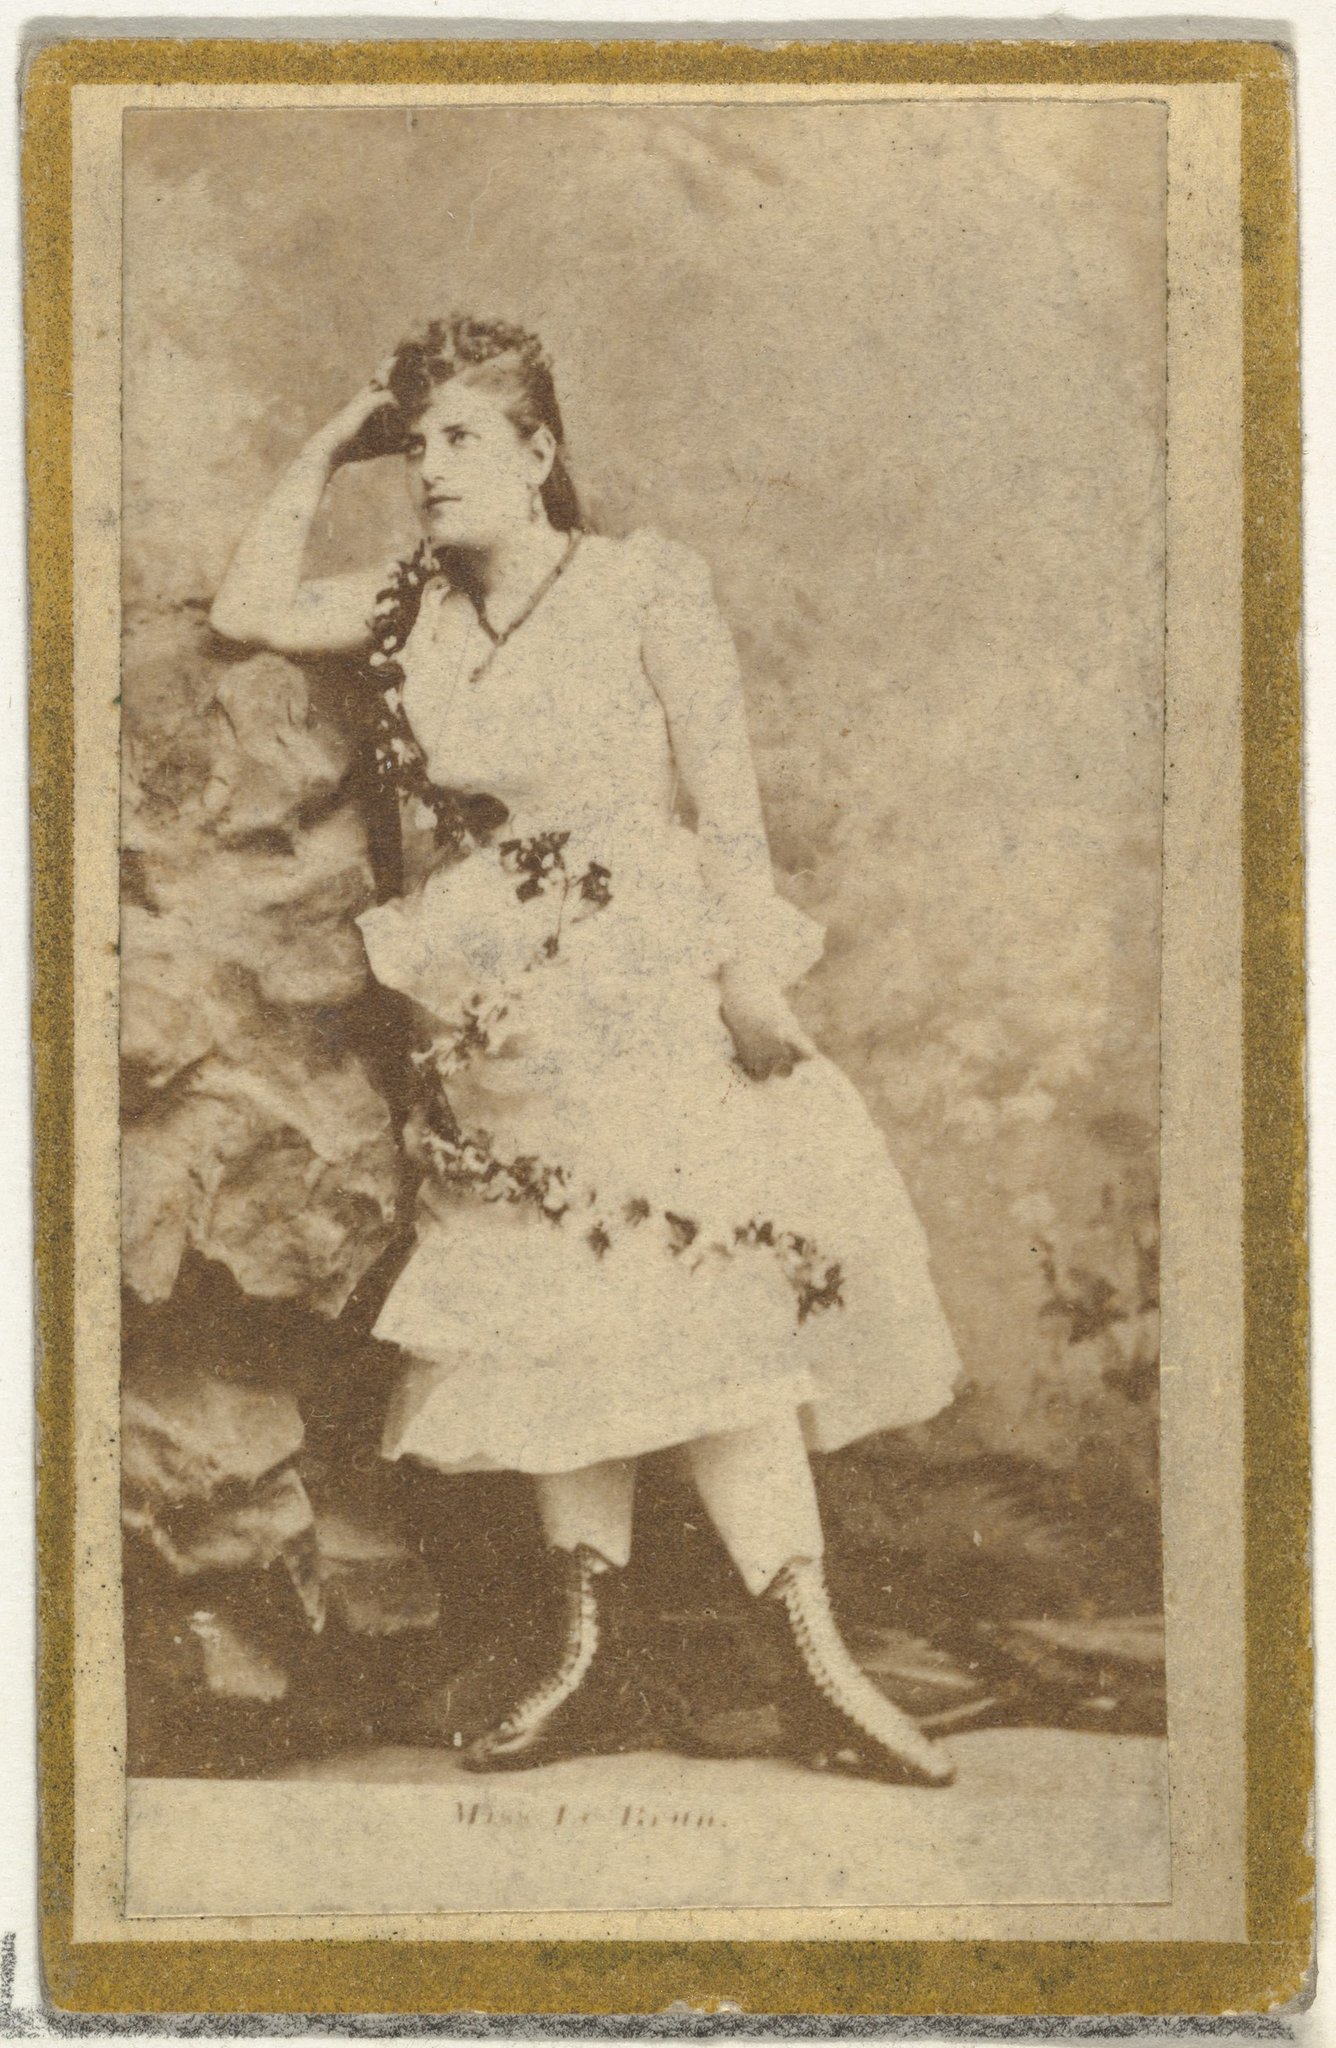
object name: photograph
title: From the Actresses and Celebrities series (N60, Type 2) promoting Little Beauties Cigarettes for Allen & Ginter brand tobacco products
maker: allen & ginter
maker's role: publisher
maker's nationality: american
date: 1887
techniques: albumen silver print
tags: portraits,women,actresses